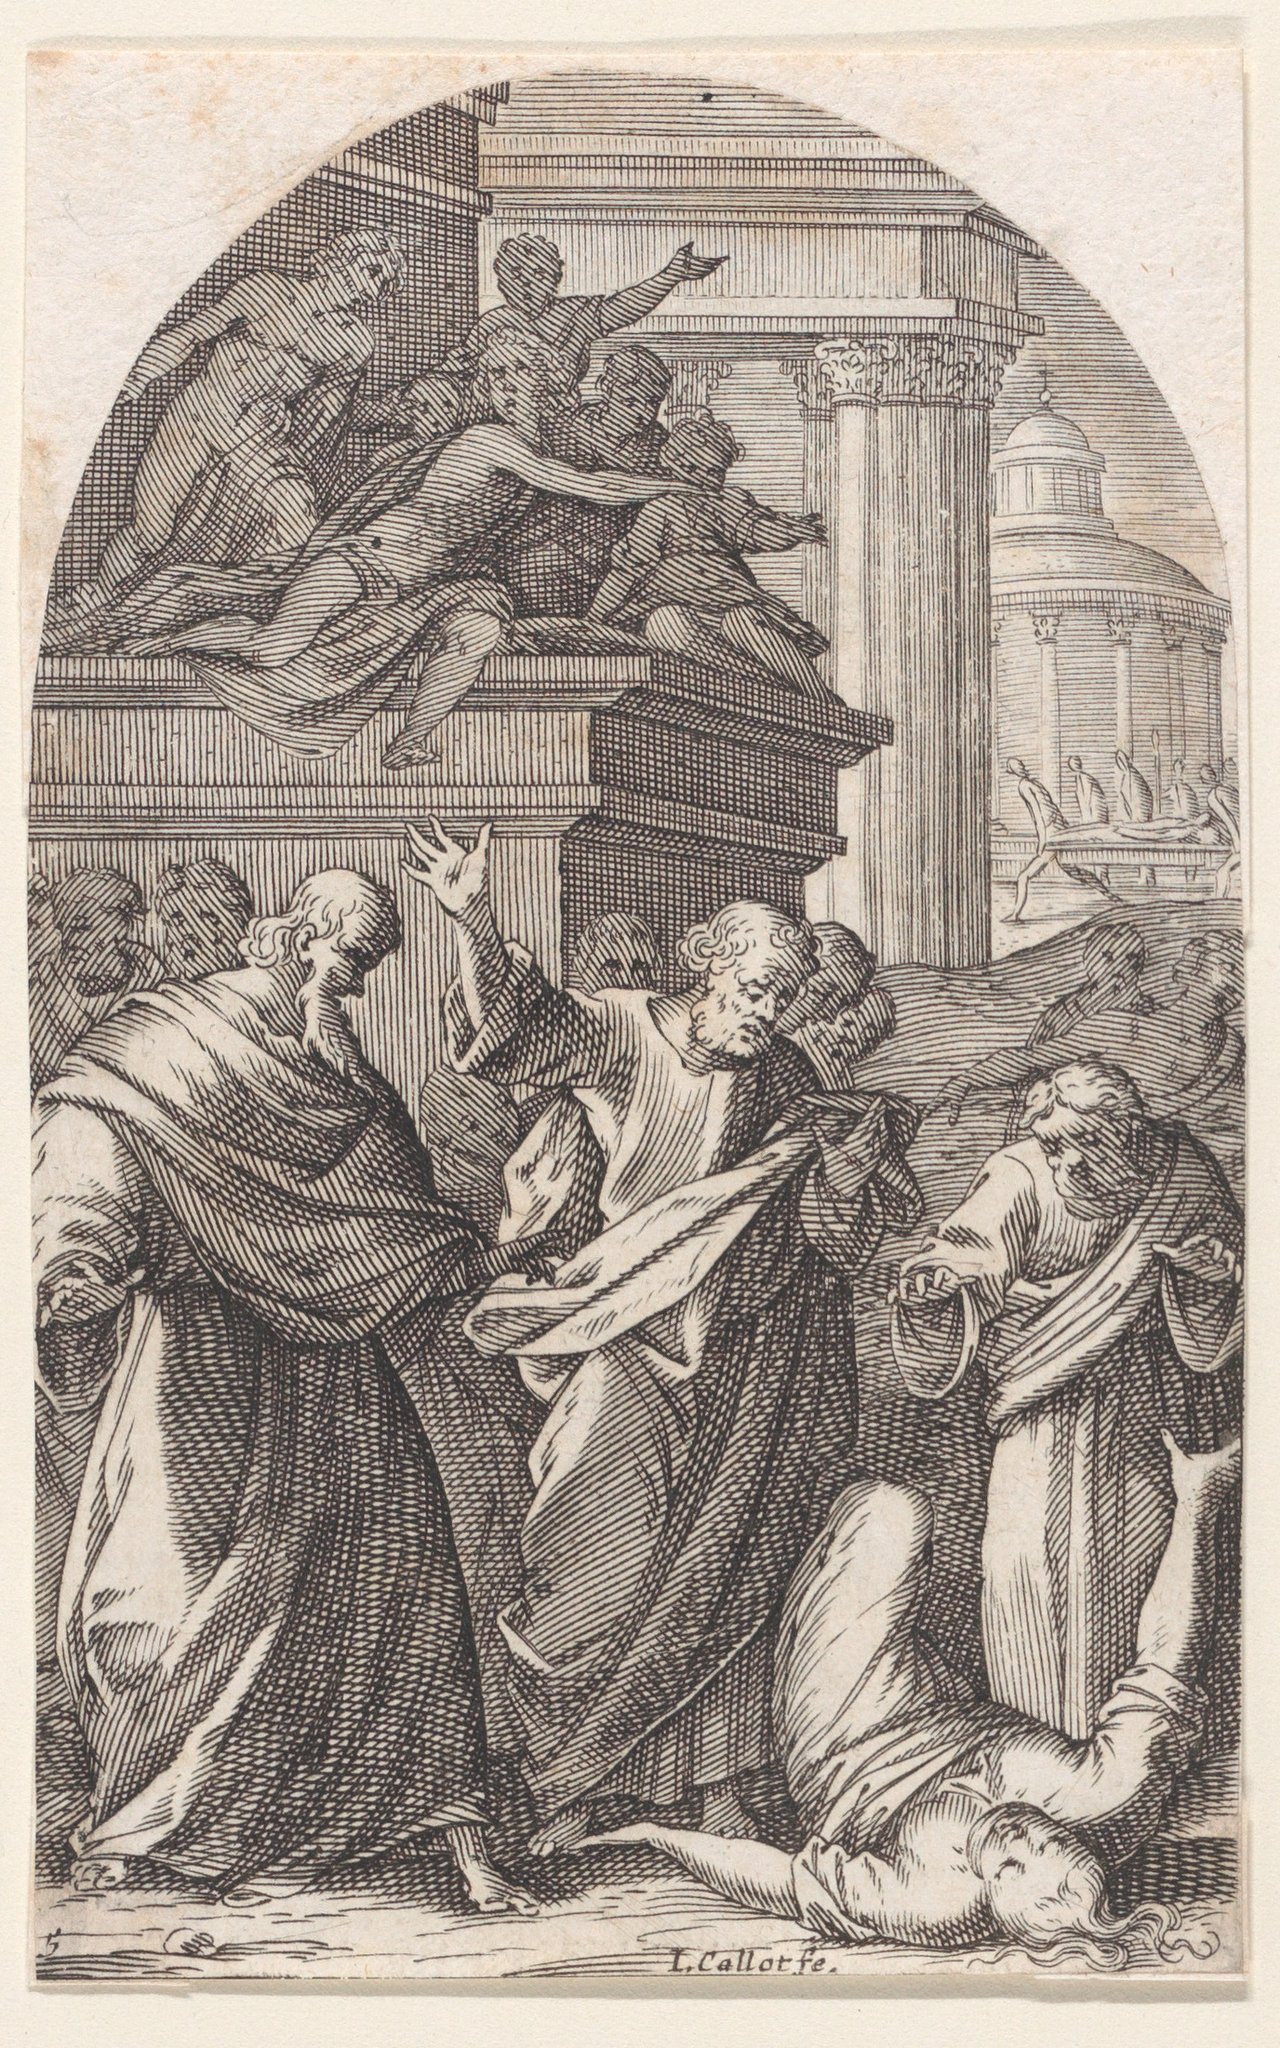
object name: print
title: Sapphira Punished by Death, plate 5 from Les Tableaux de Rome, Les Eglises Jubilaires (The Paintings of Rome, The Churches Jubilee)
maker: jacques callot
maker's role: artist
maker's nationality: french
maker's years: 1592-1635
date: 1607-1611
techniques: engraving